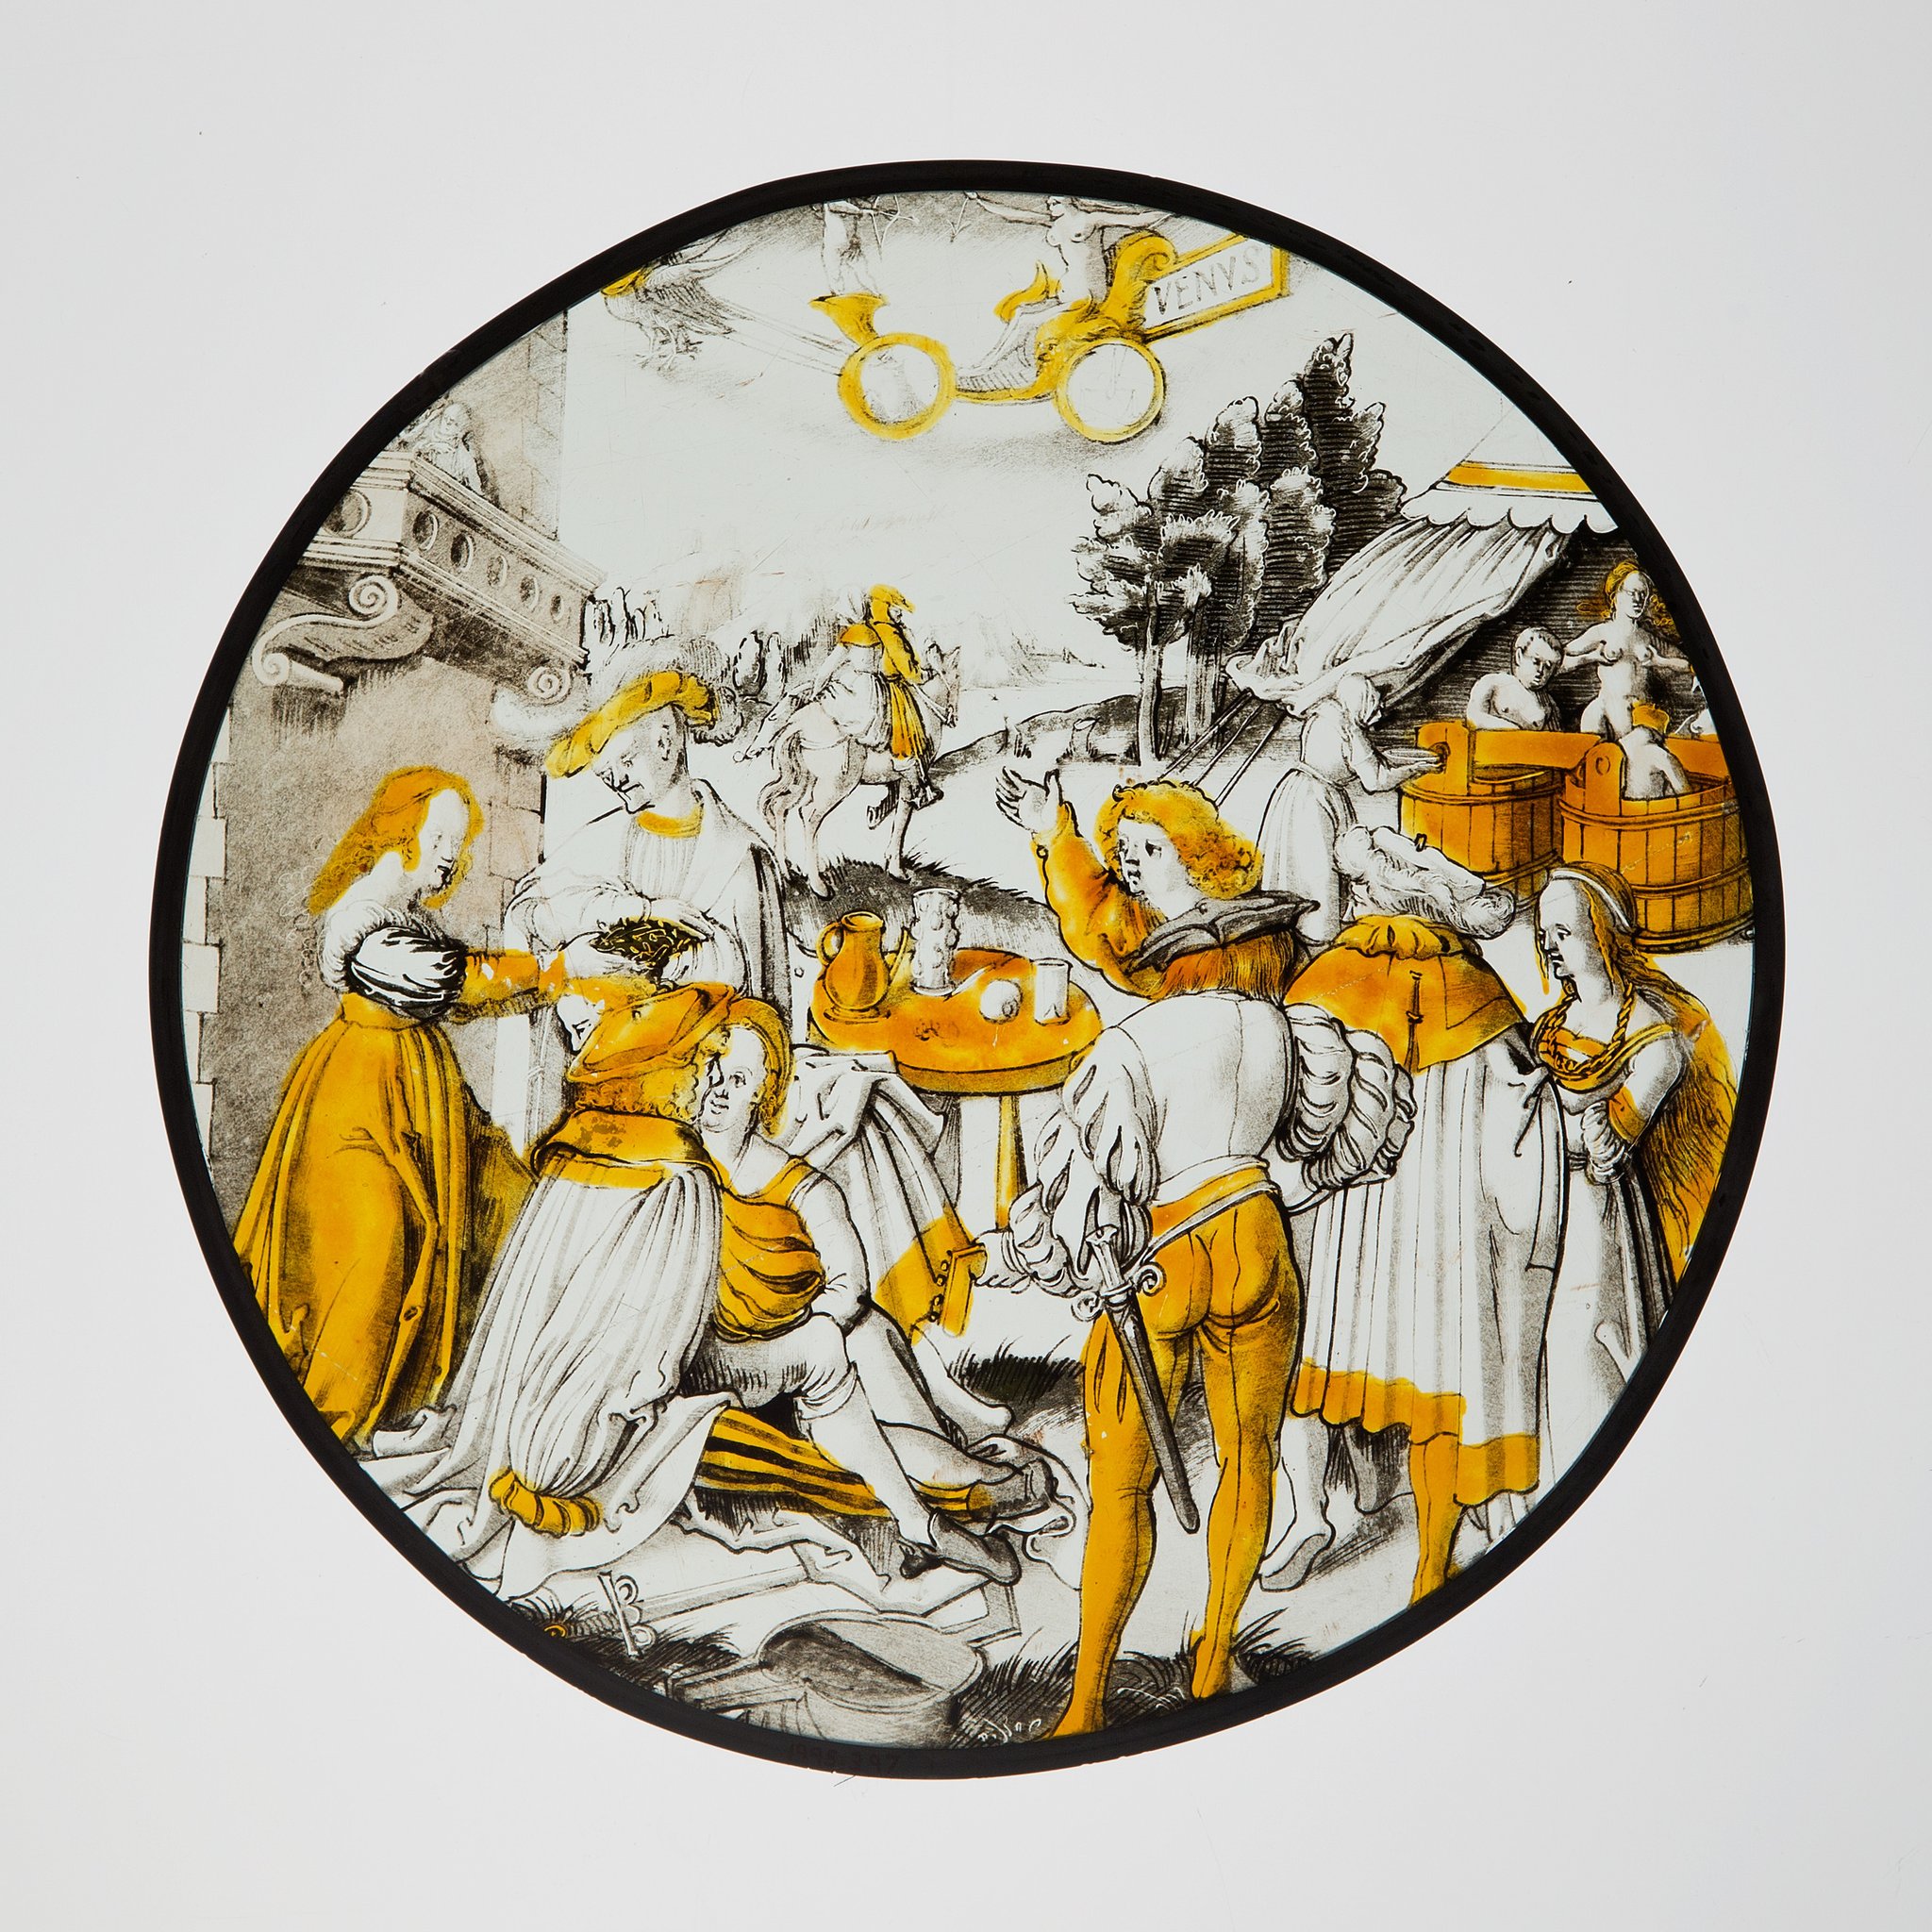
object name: roundel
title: Roundel of The Planet Venus and Her Children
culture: german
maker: jörg breu the elder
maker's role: artist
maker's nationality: german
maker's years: 1480-1537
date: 1520-1530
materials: glass, paint, pigment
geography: germany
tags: men,women,venus,bathing